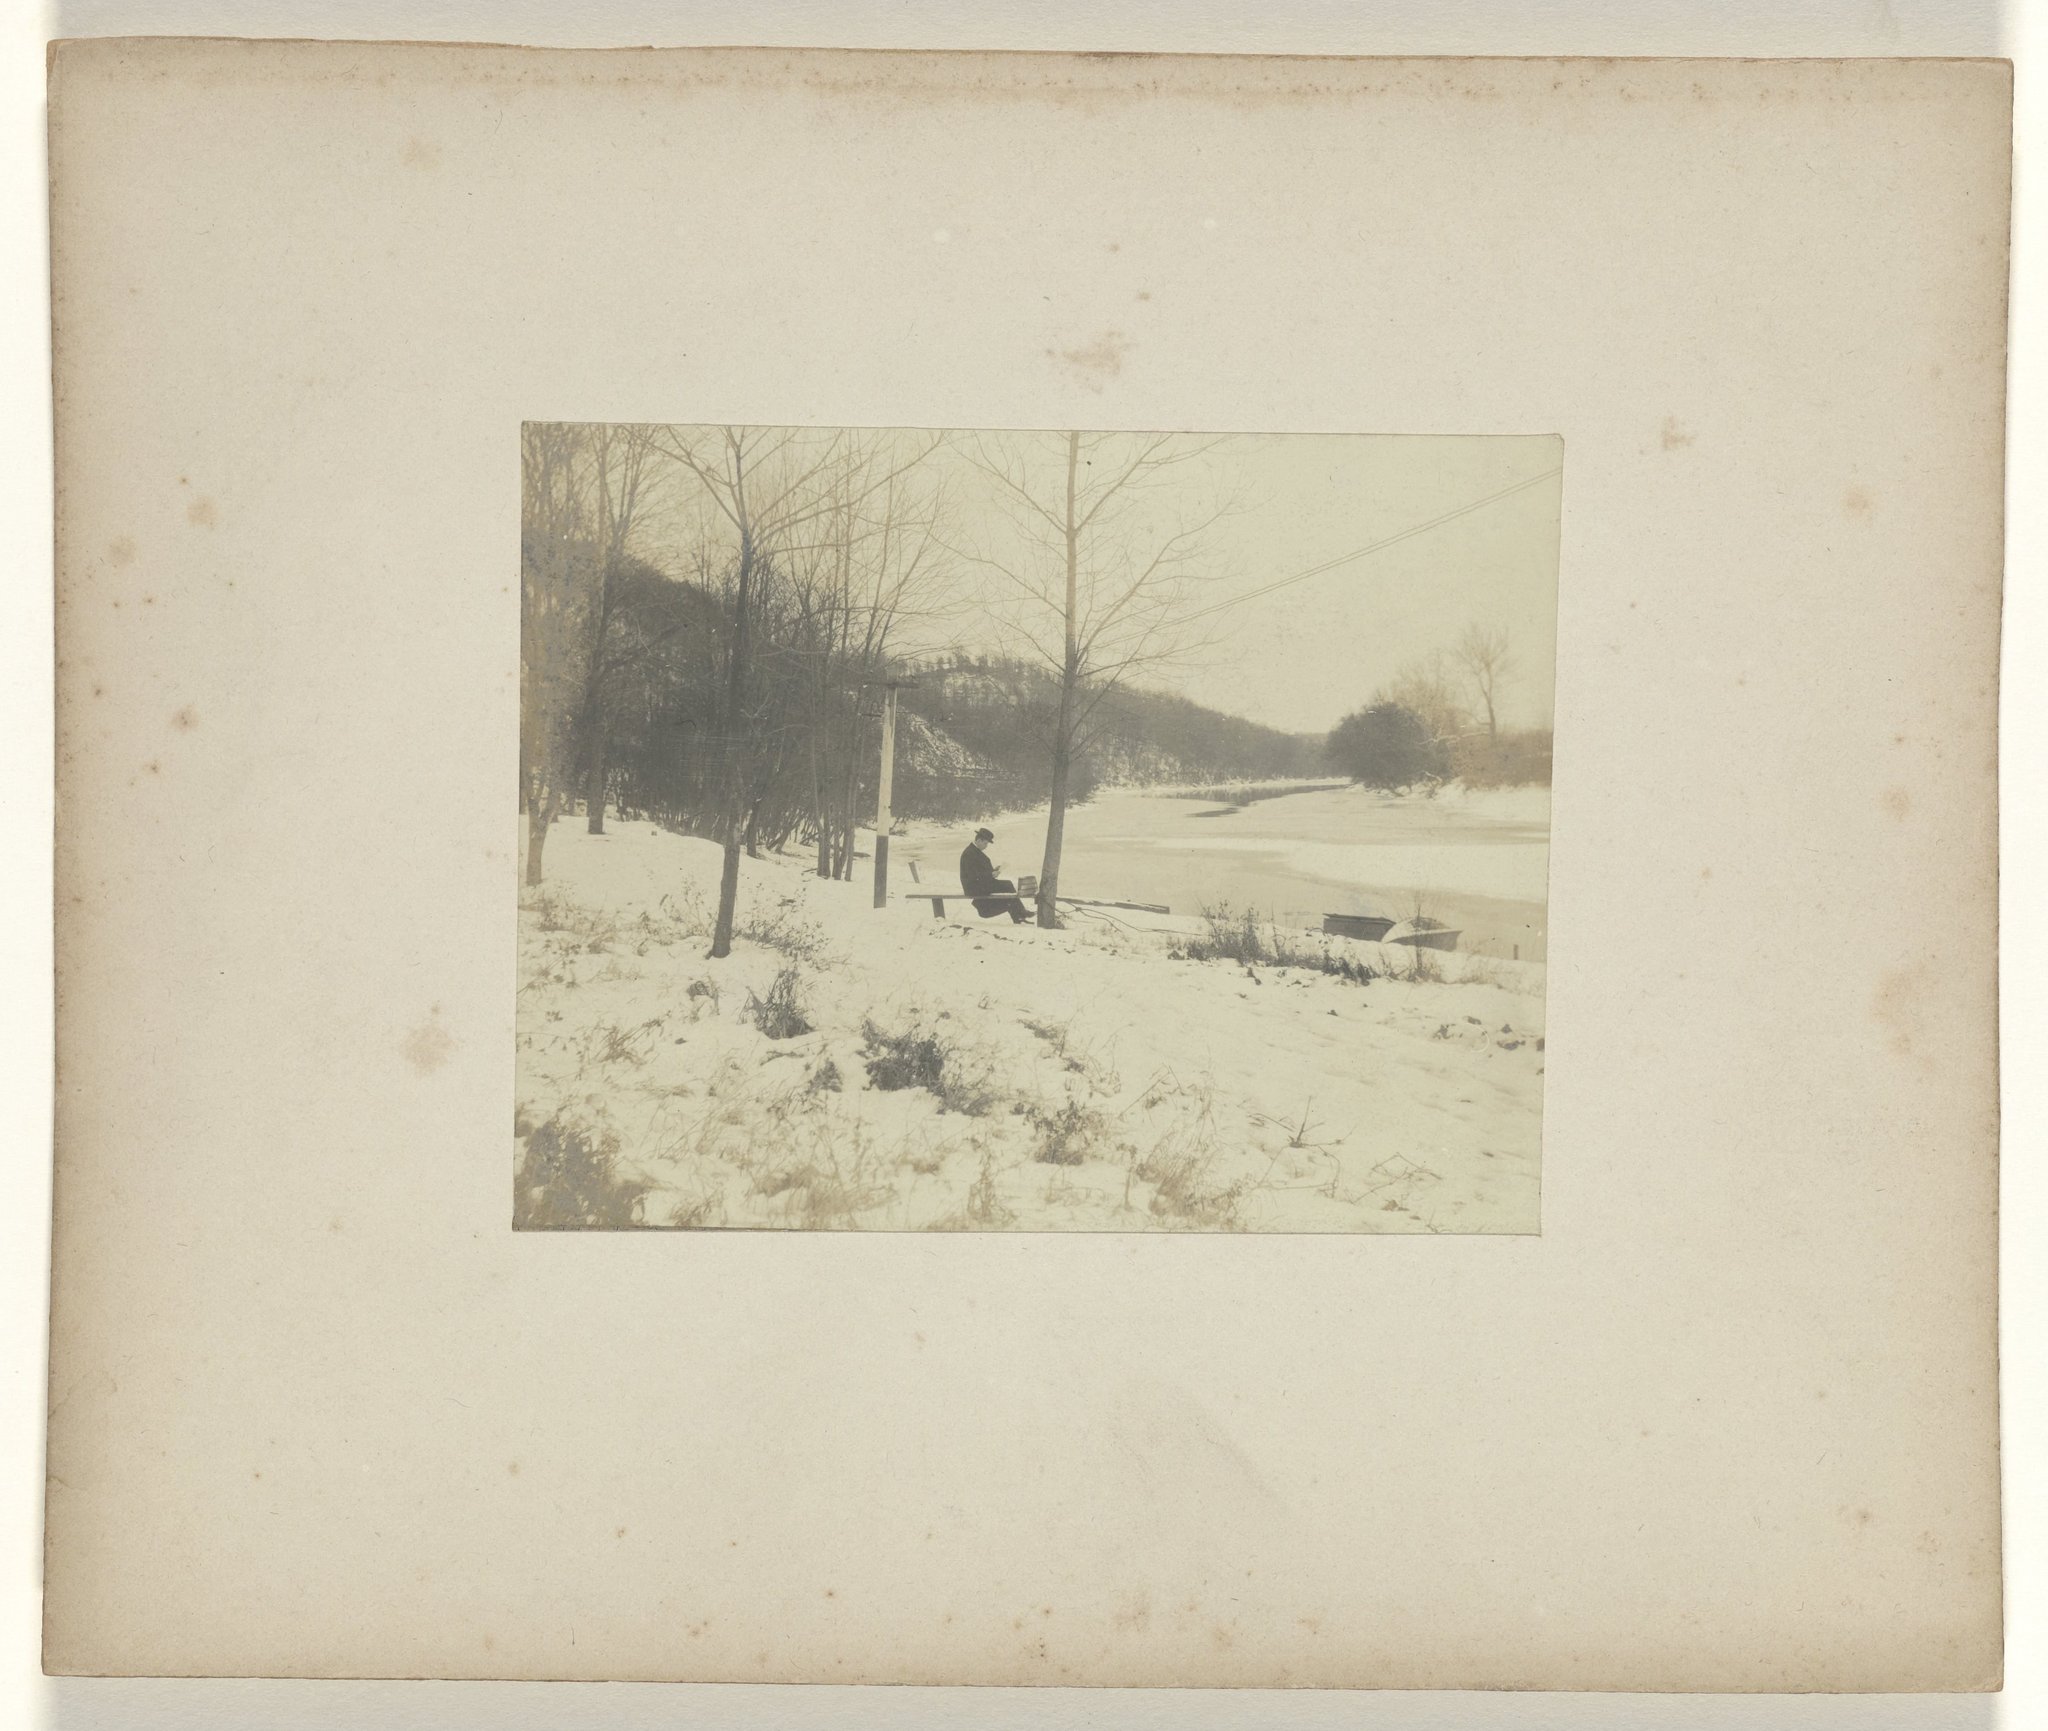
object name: photograph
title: Jan C. Schüller aan de oever van de Meramec rivier tijdens de wereldtentoonstelling in St. Louis (Louisiana Purchase Exposition), 1904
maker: Anonymous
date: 1904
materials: cardboard, paper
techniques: gelatin silver print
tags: print maker, draughtsman, jan schüller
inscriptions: annotation: ‘Meramec rivier // zuidwaarts gezien’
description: Jan C. Schüller aan de oever van de Meramec rivier tijdens de wereldtentoonstelling in St. Louis (Louisiana Purchase Exposition), 1904.